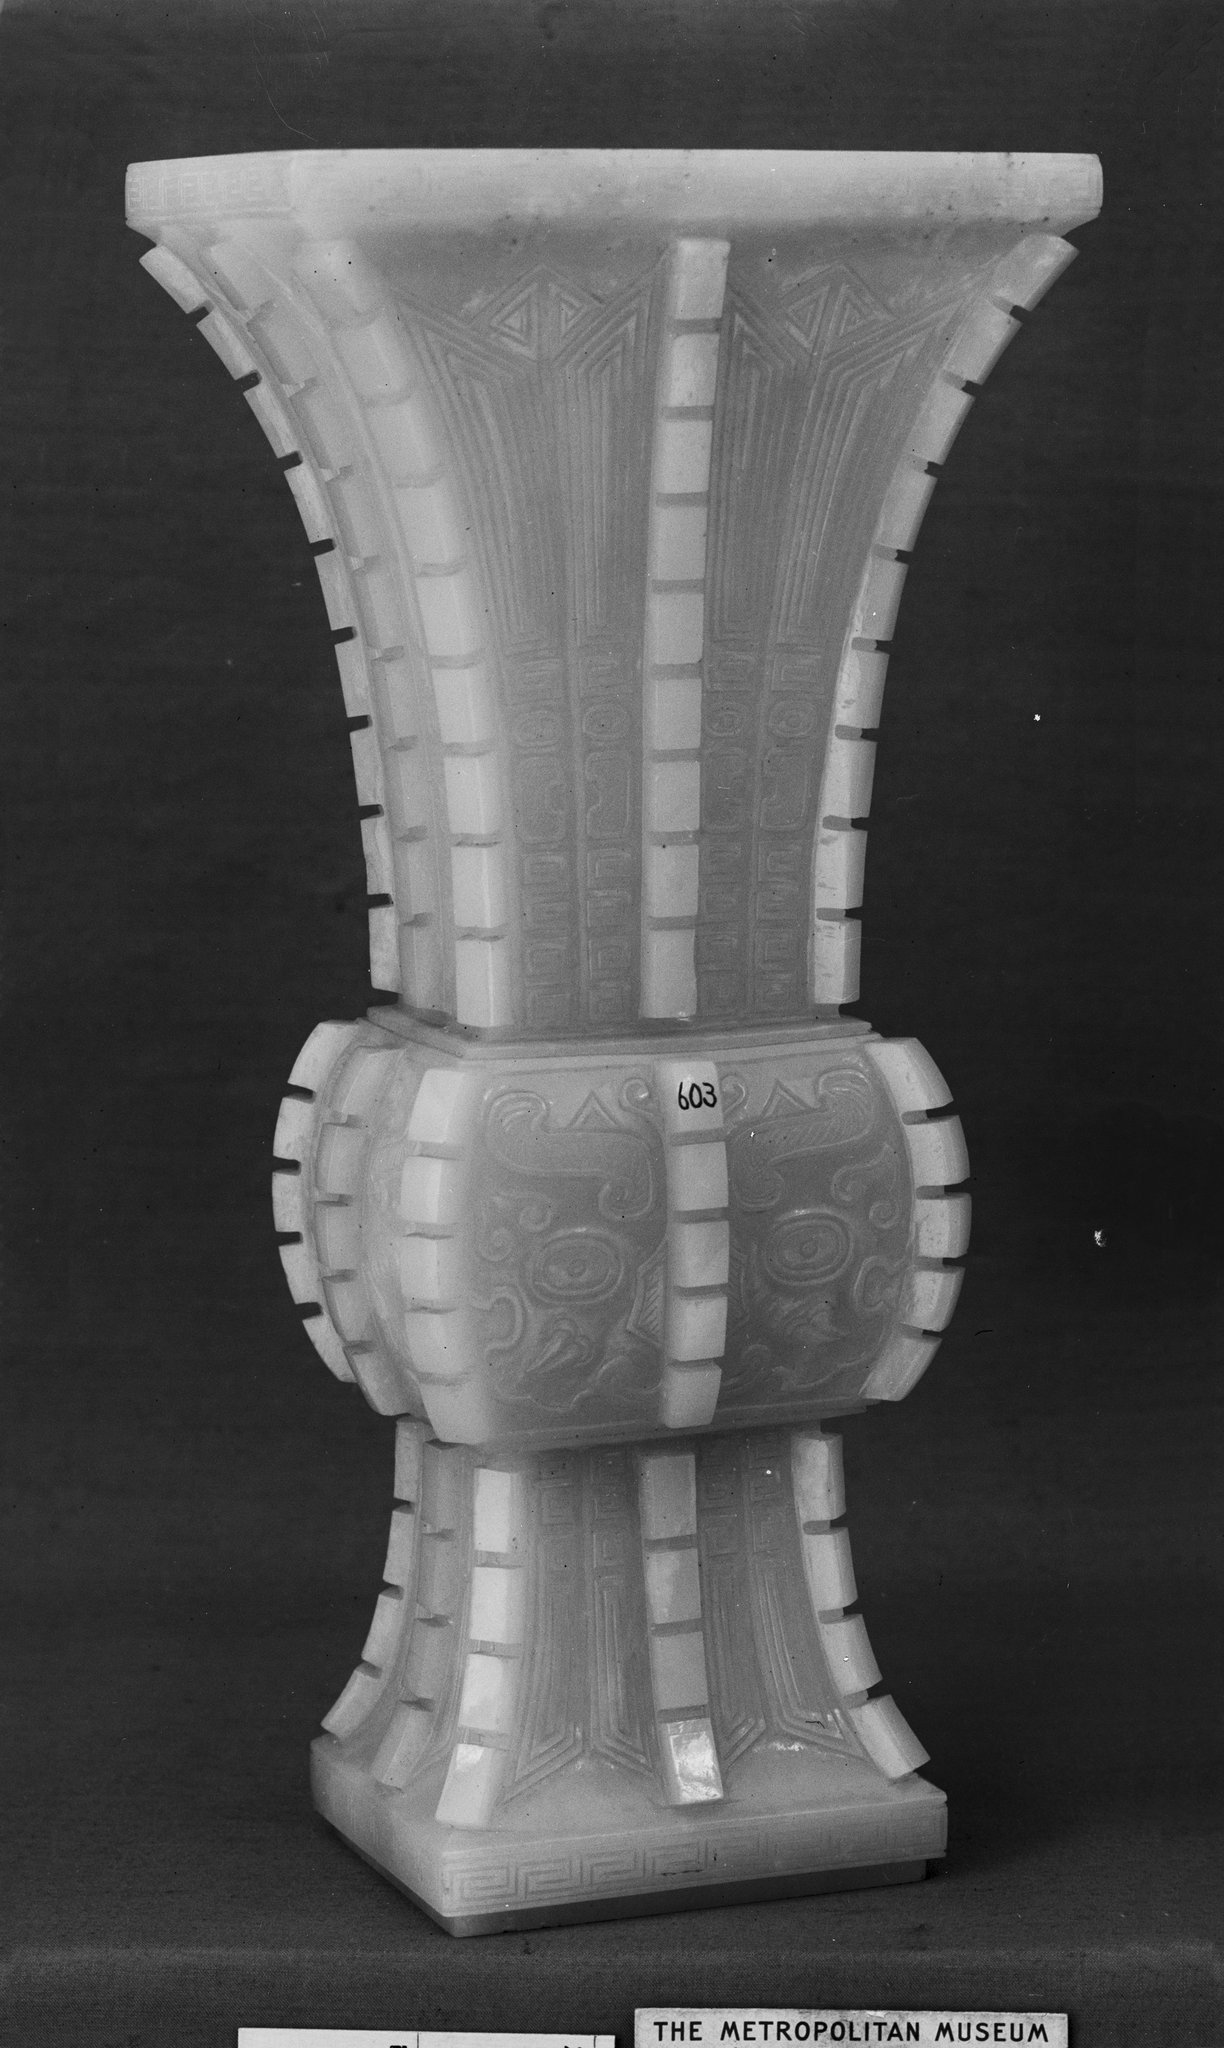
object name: vase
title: Vase in the shape of an ancient ritual vessel (gu)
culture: chinese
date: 1701-1900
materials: jade